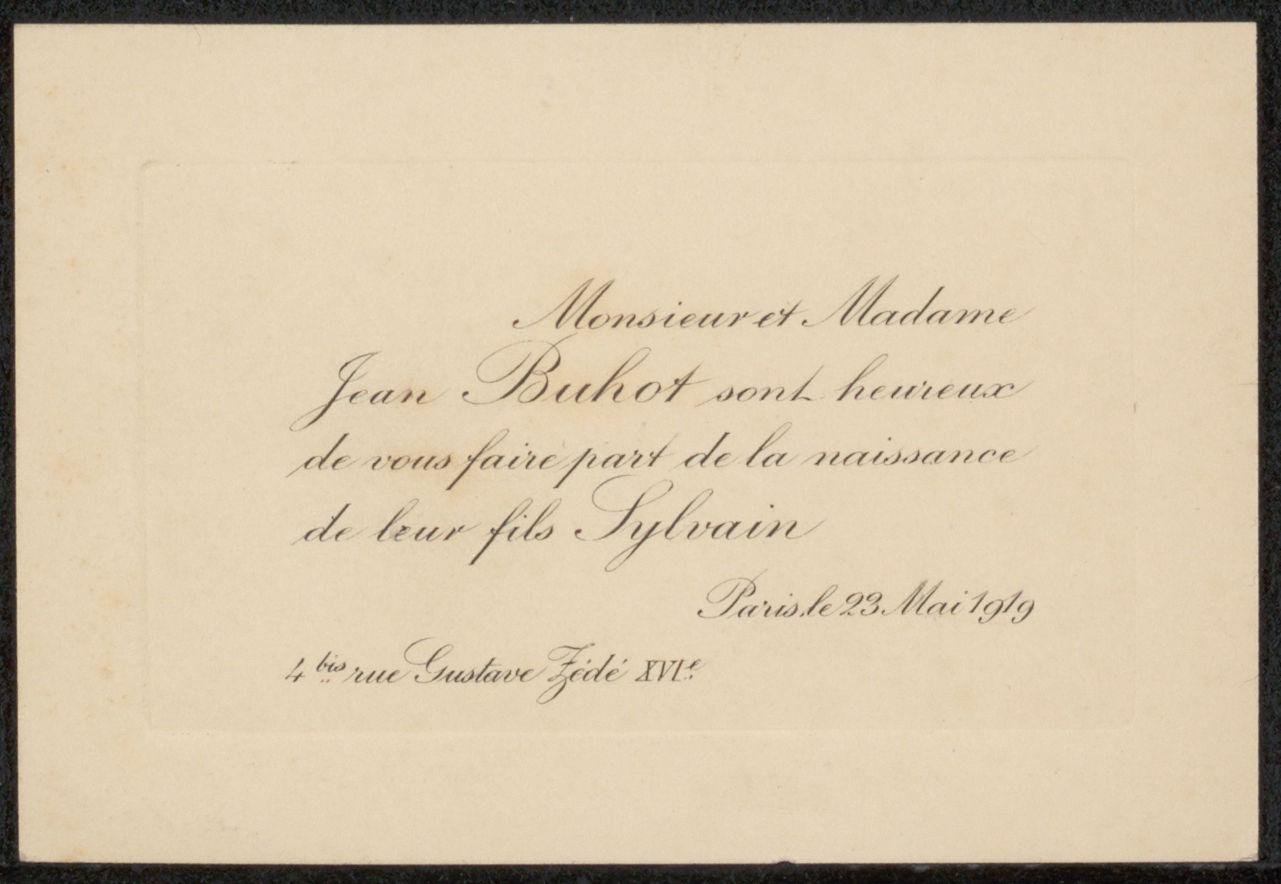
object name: birth announcement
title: Geboortekaart aan Philip Zilcken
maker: Anonymous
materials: cardboard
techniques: printing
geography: france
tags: paris, jean buhot, the hague, painter, draughtsman, philip zilcken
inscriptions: collector's mark: ‘RPK’